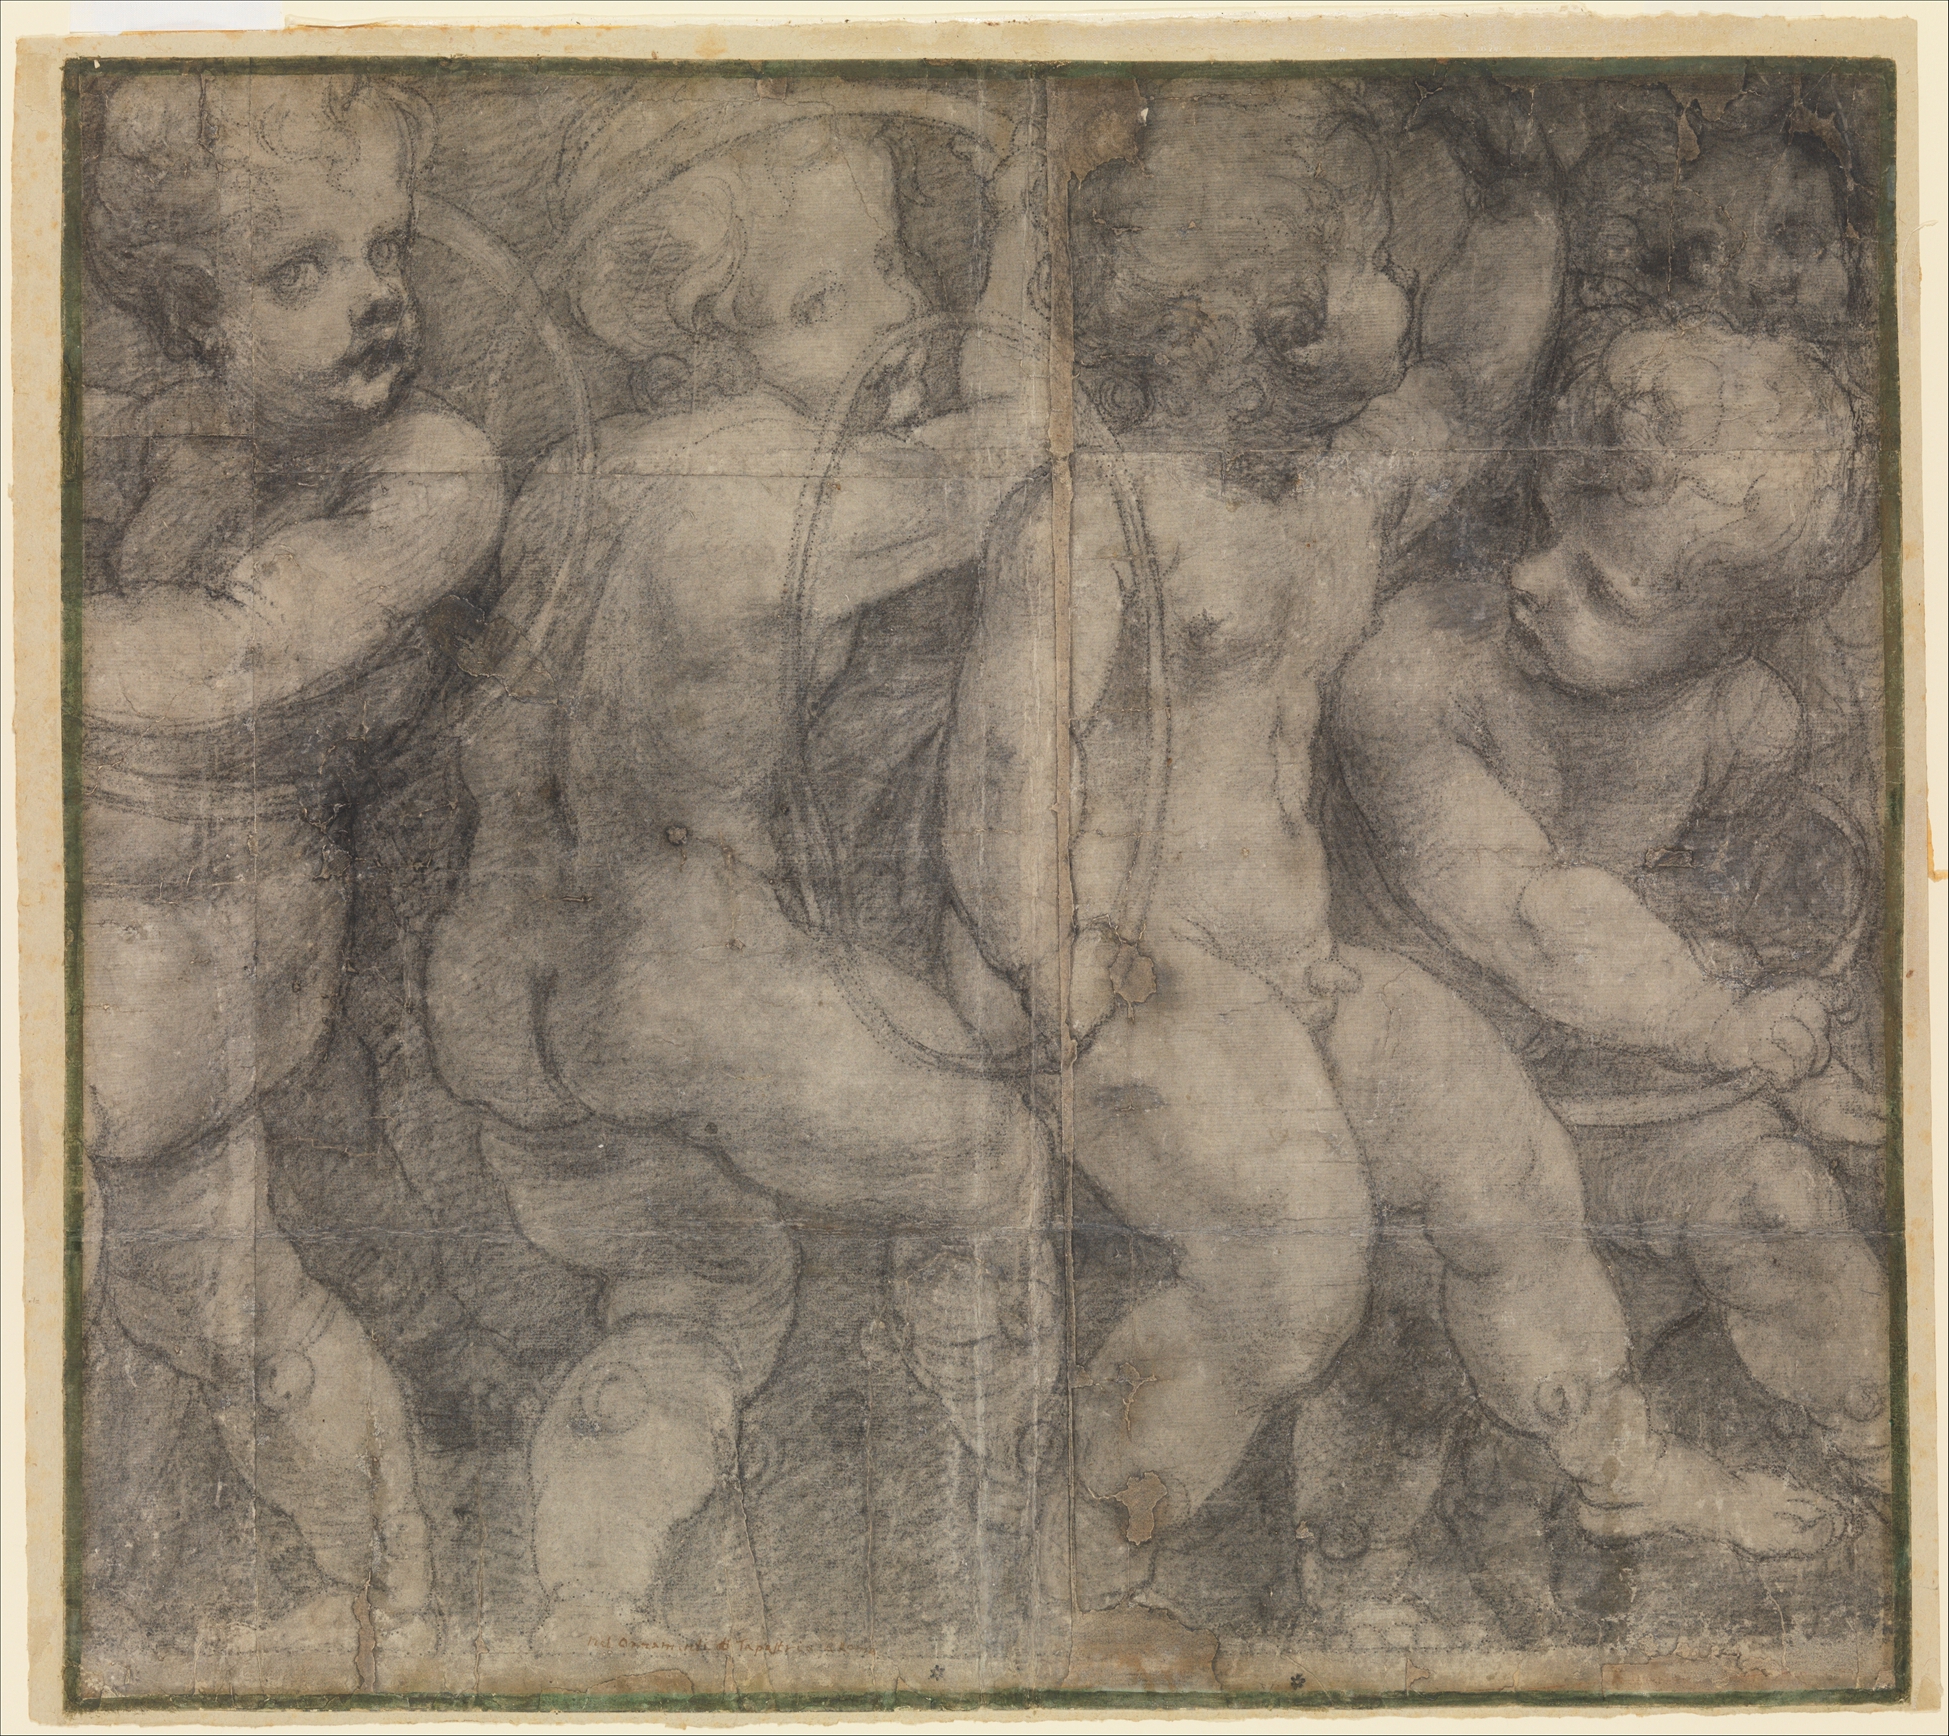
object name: drawing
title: Putti Playing with Hoops (Cartoon for a Fresco in Parma Cathedral)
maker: michelangelo anselmi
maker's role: artist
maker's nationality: italian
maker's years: 1492-1556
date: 1548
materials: chalk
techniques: transfer